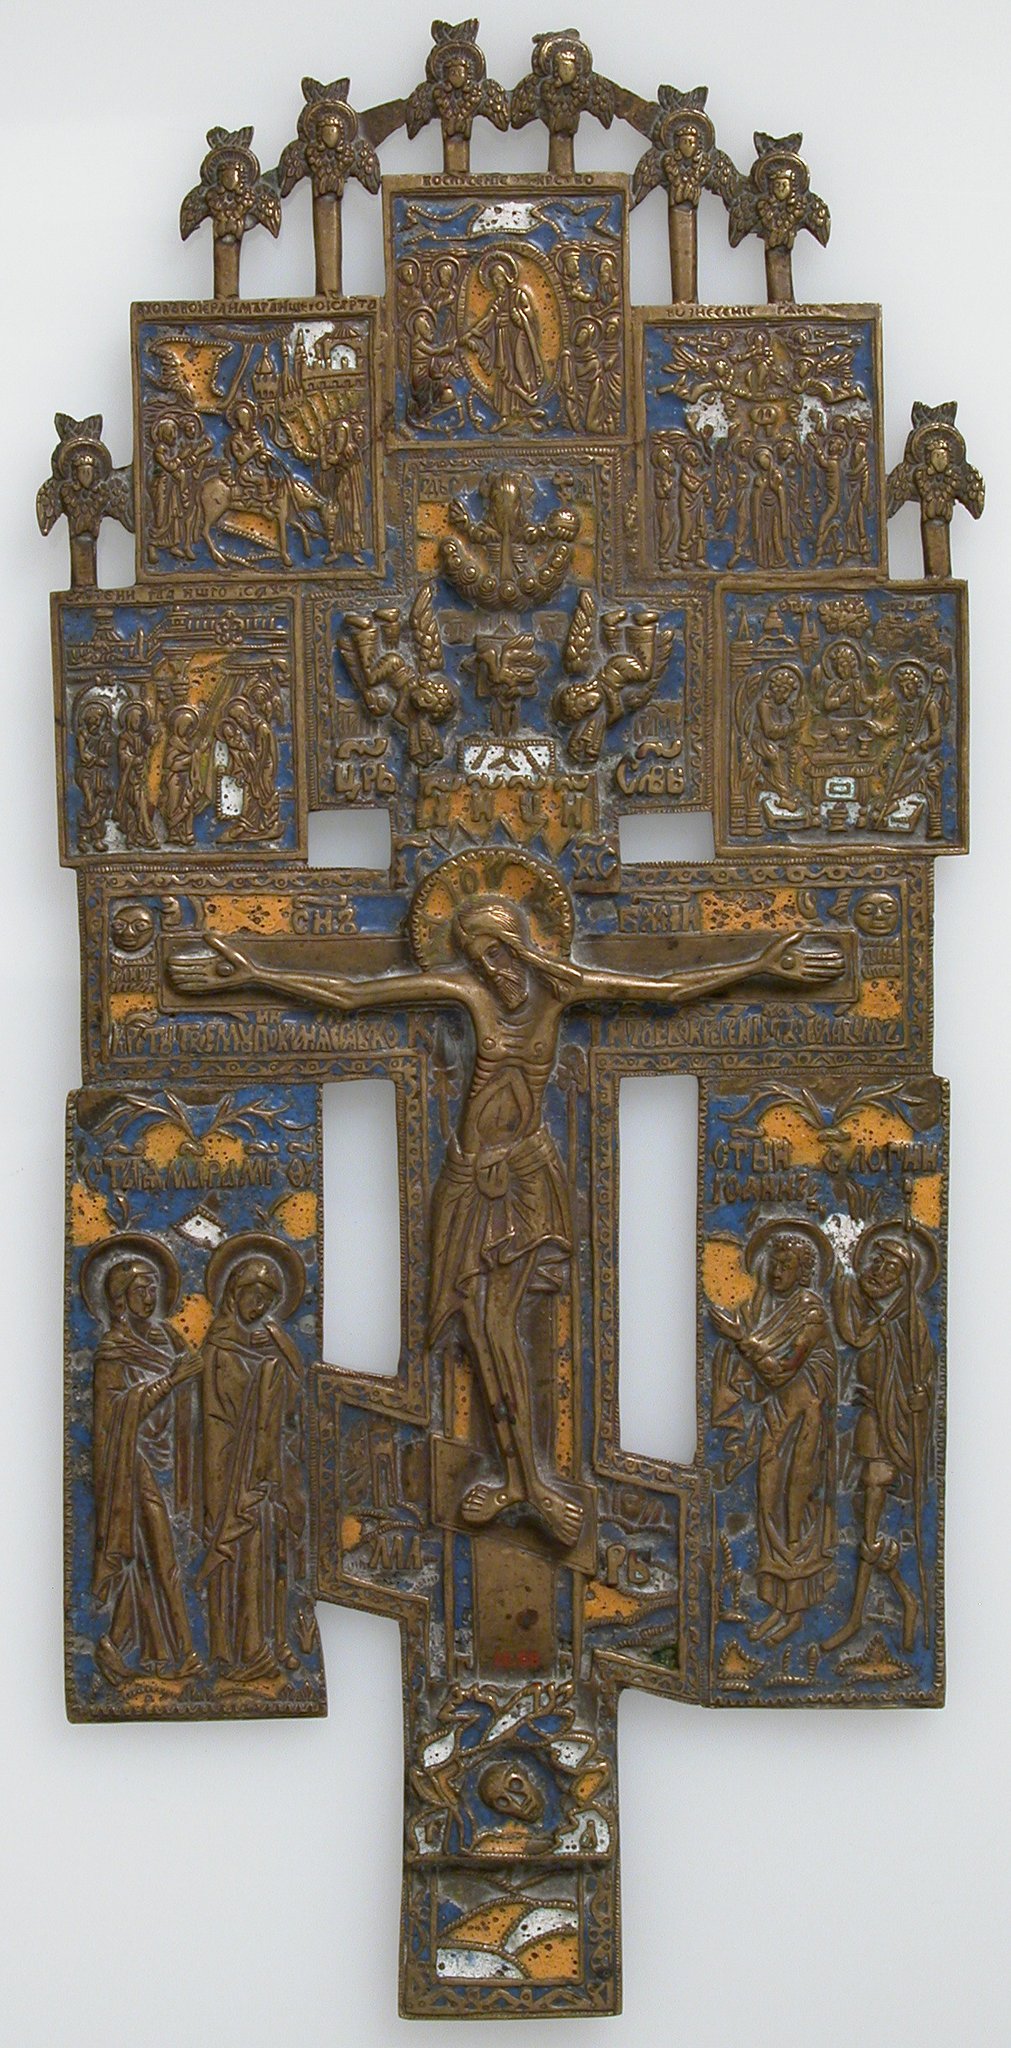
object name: icon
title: Devotional Icon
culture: russian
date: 1801-1900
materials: copper alloy, enamel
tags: men,women,angels,crucifixion